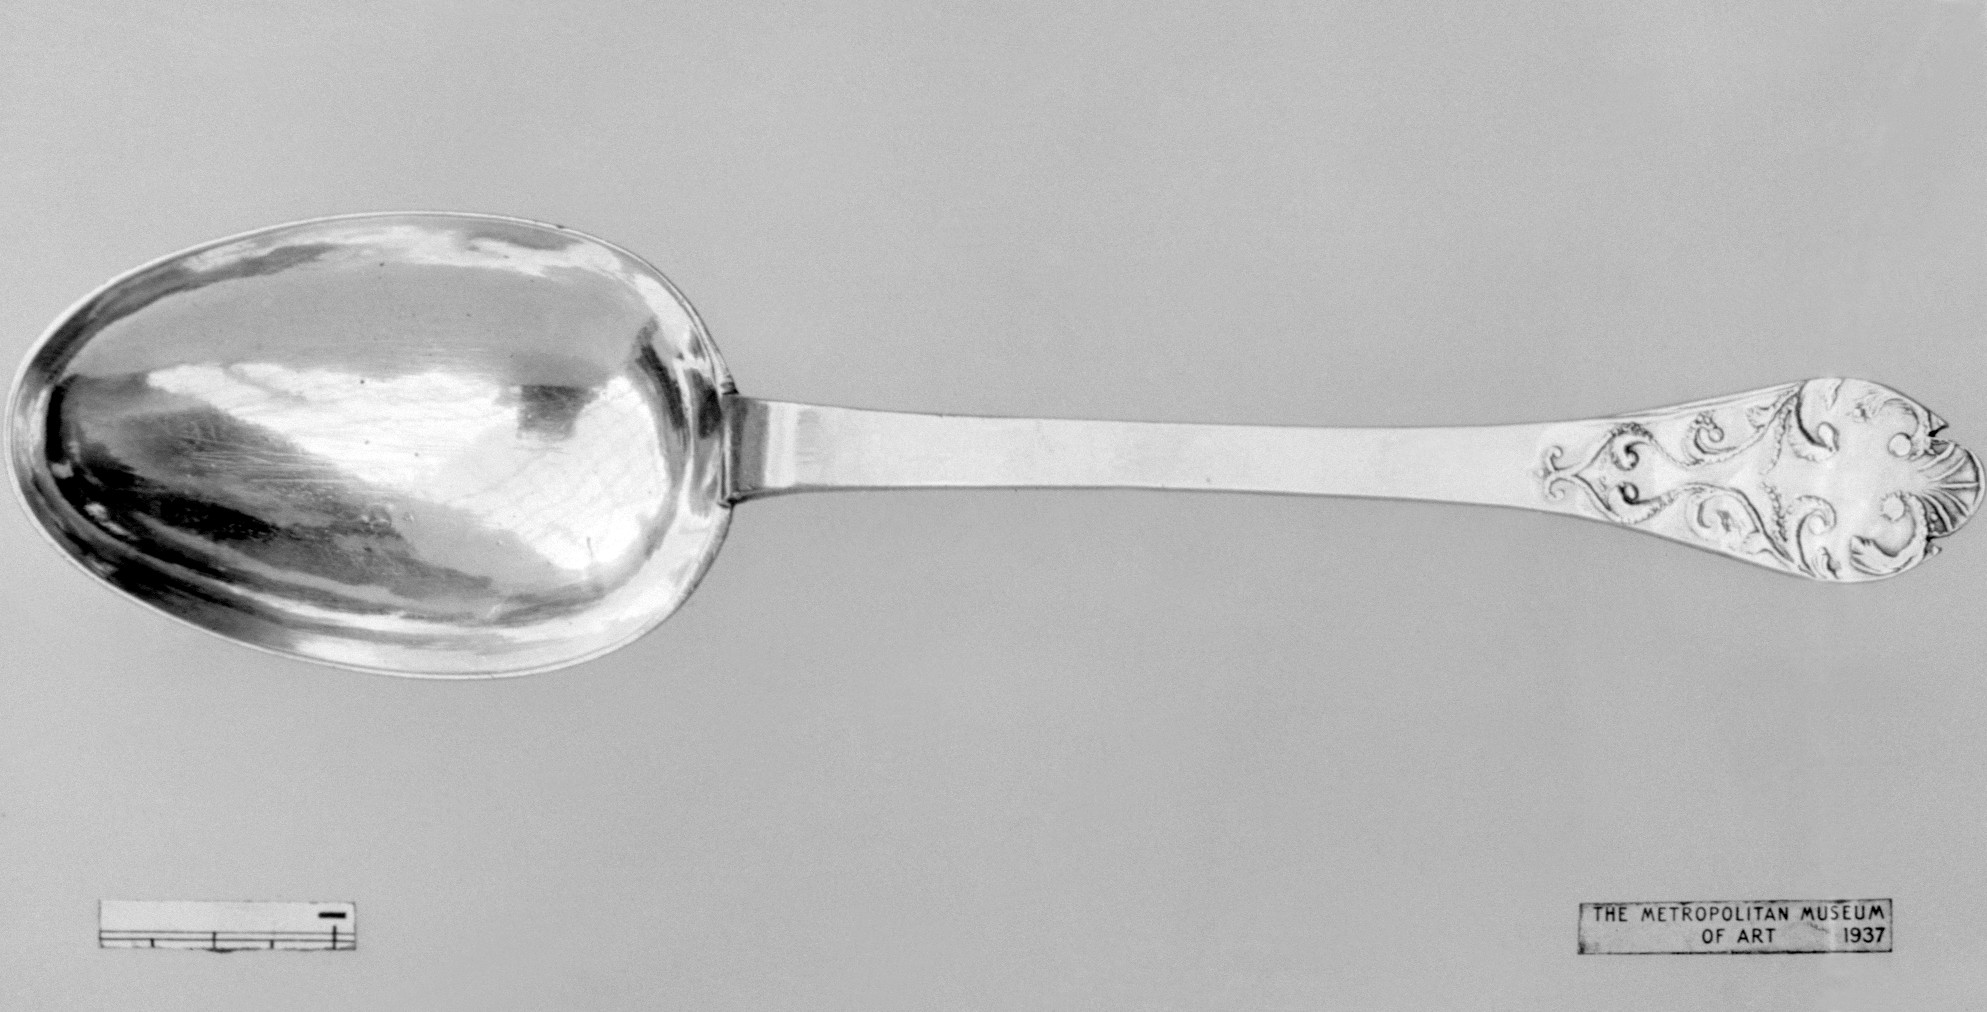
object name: spoon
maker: edward sweet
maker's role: maker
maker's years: 1704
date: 1704-1705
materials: silver